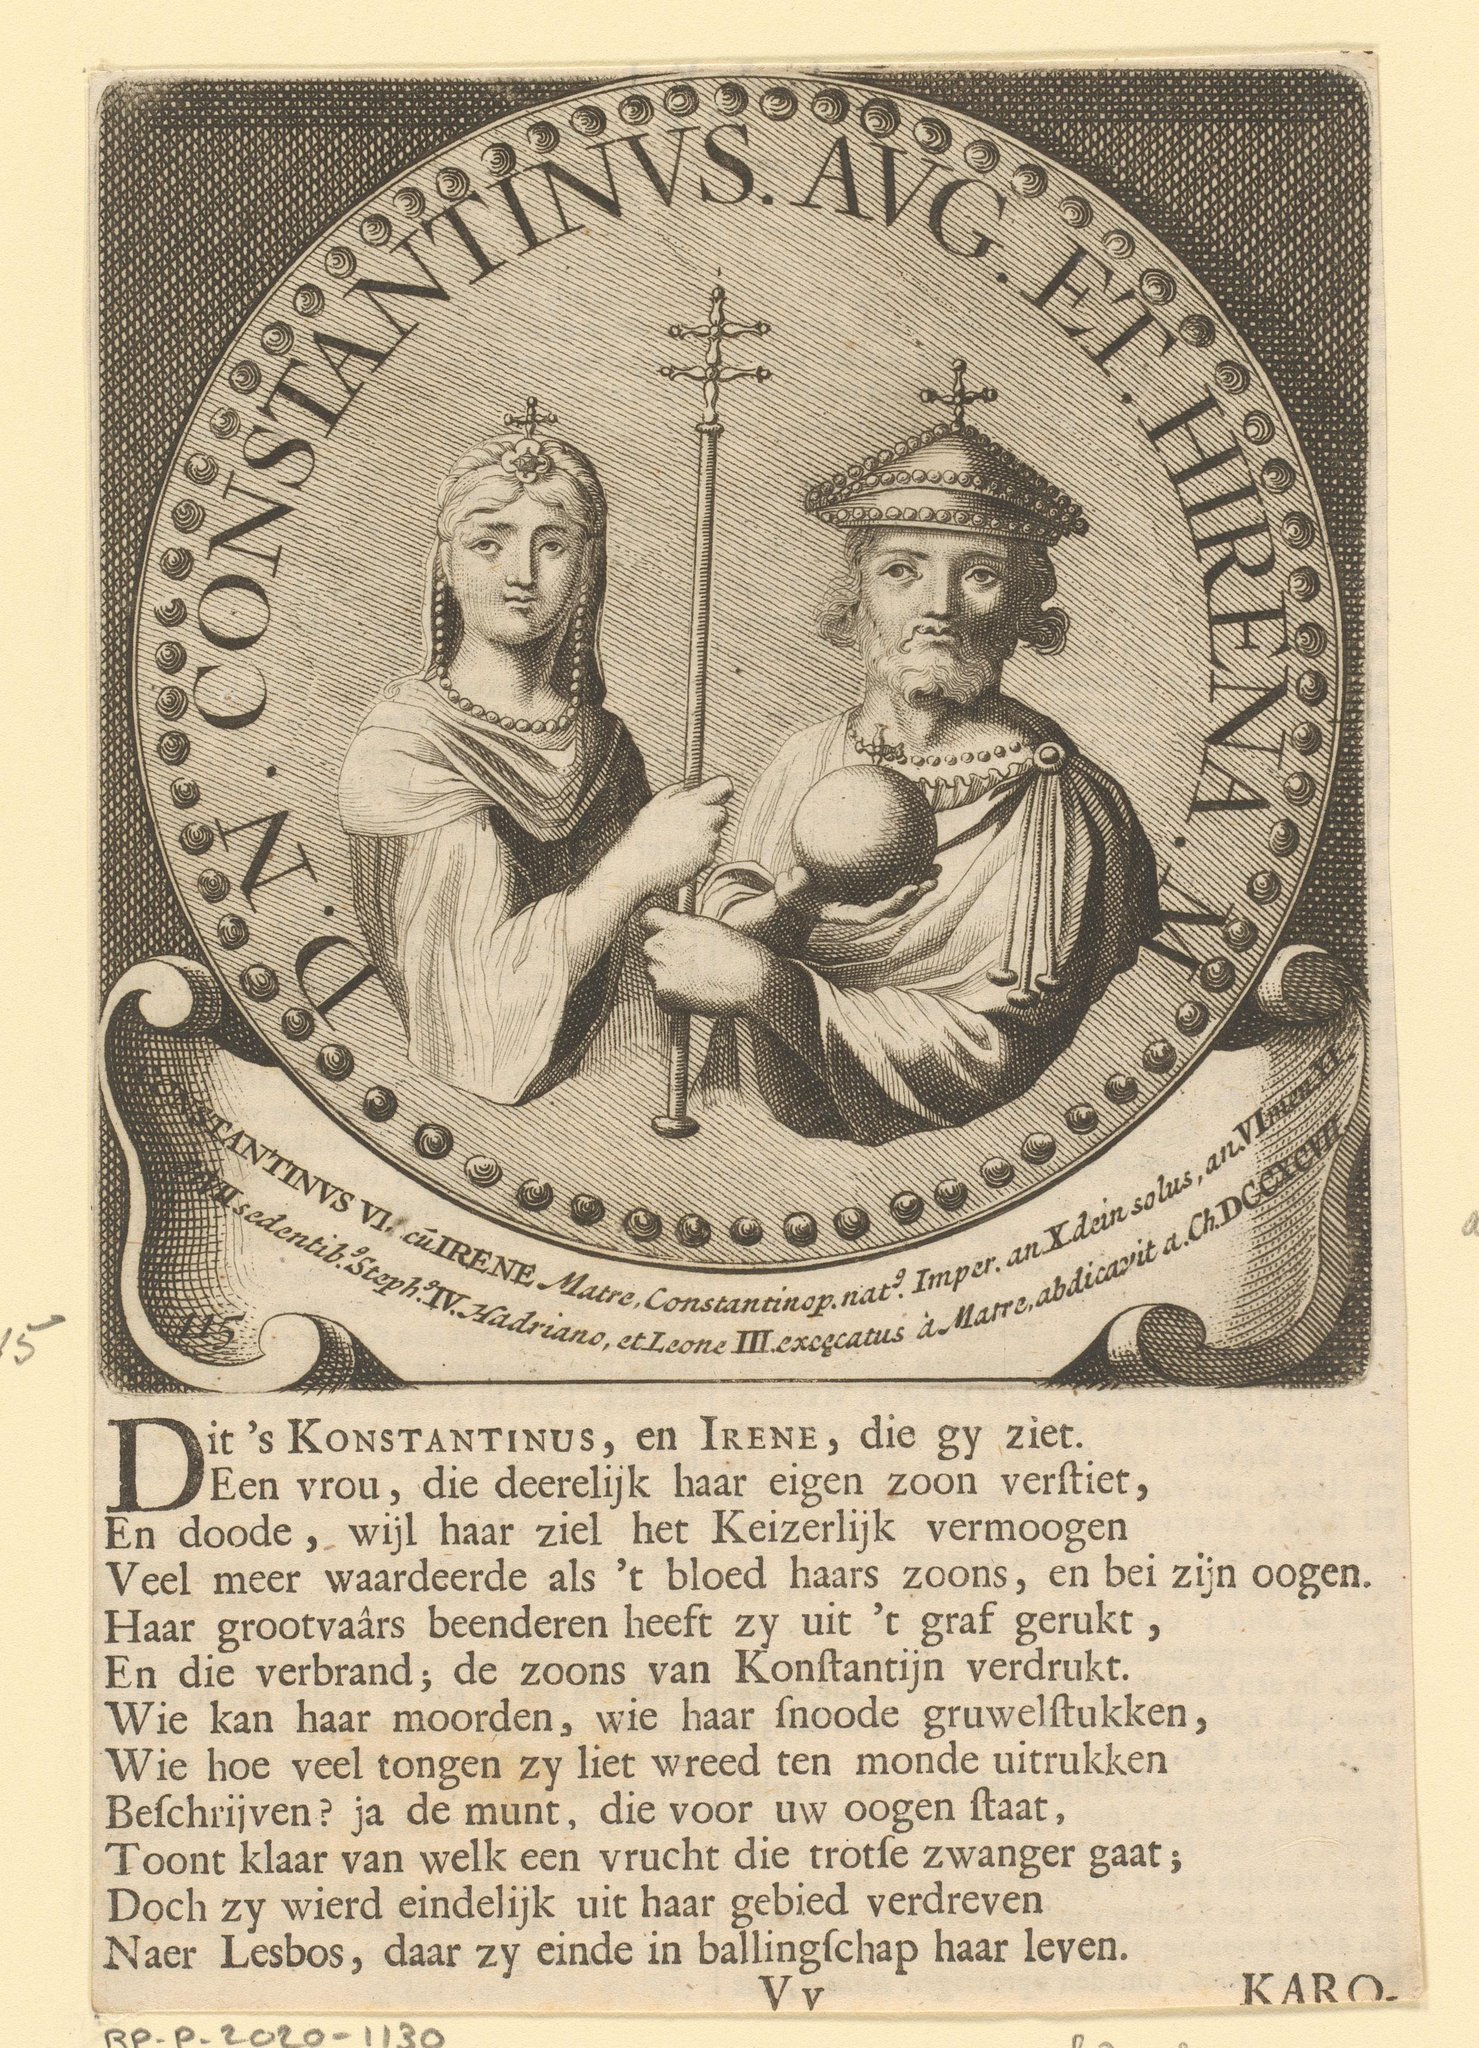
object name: book illustration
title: Constantinus VI cu[m] Irene matre (...)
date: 1697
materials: paper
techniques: engraving, etching, letterpress printing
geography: utrecht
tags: historical persons, emperor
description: Prent uit: Bogaert, Abraham. De Roomsche monarchy, vertoont in de muntbeelden der westersche en oostersche keizeren (...). Utrecht: François Halma en Willem van de Water, 1697, p. 337. Eerste staat verschenen in een grotere prent met twaalf portretten, gedateerd 1695.